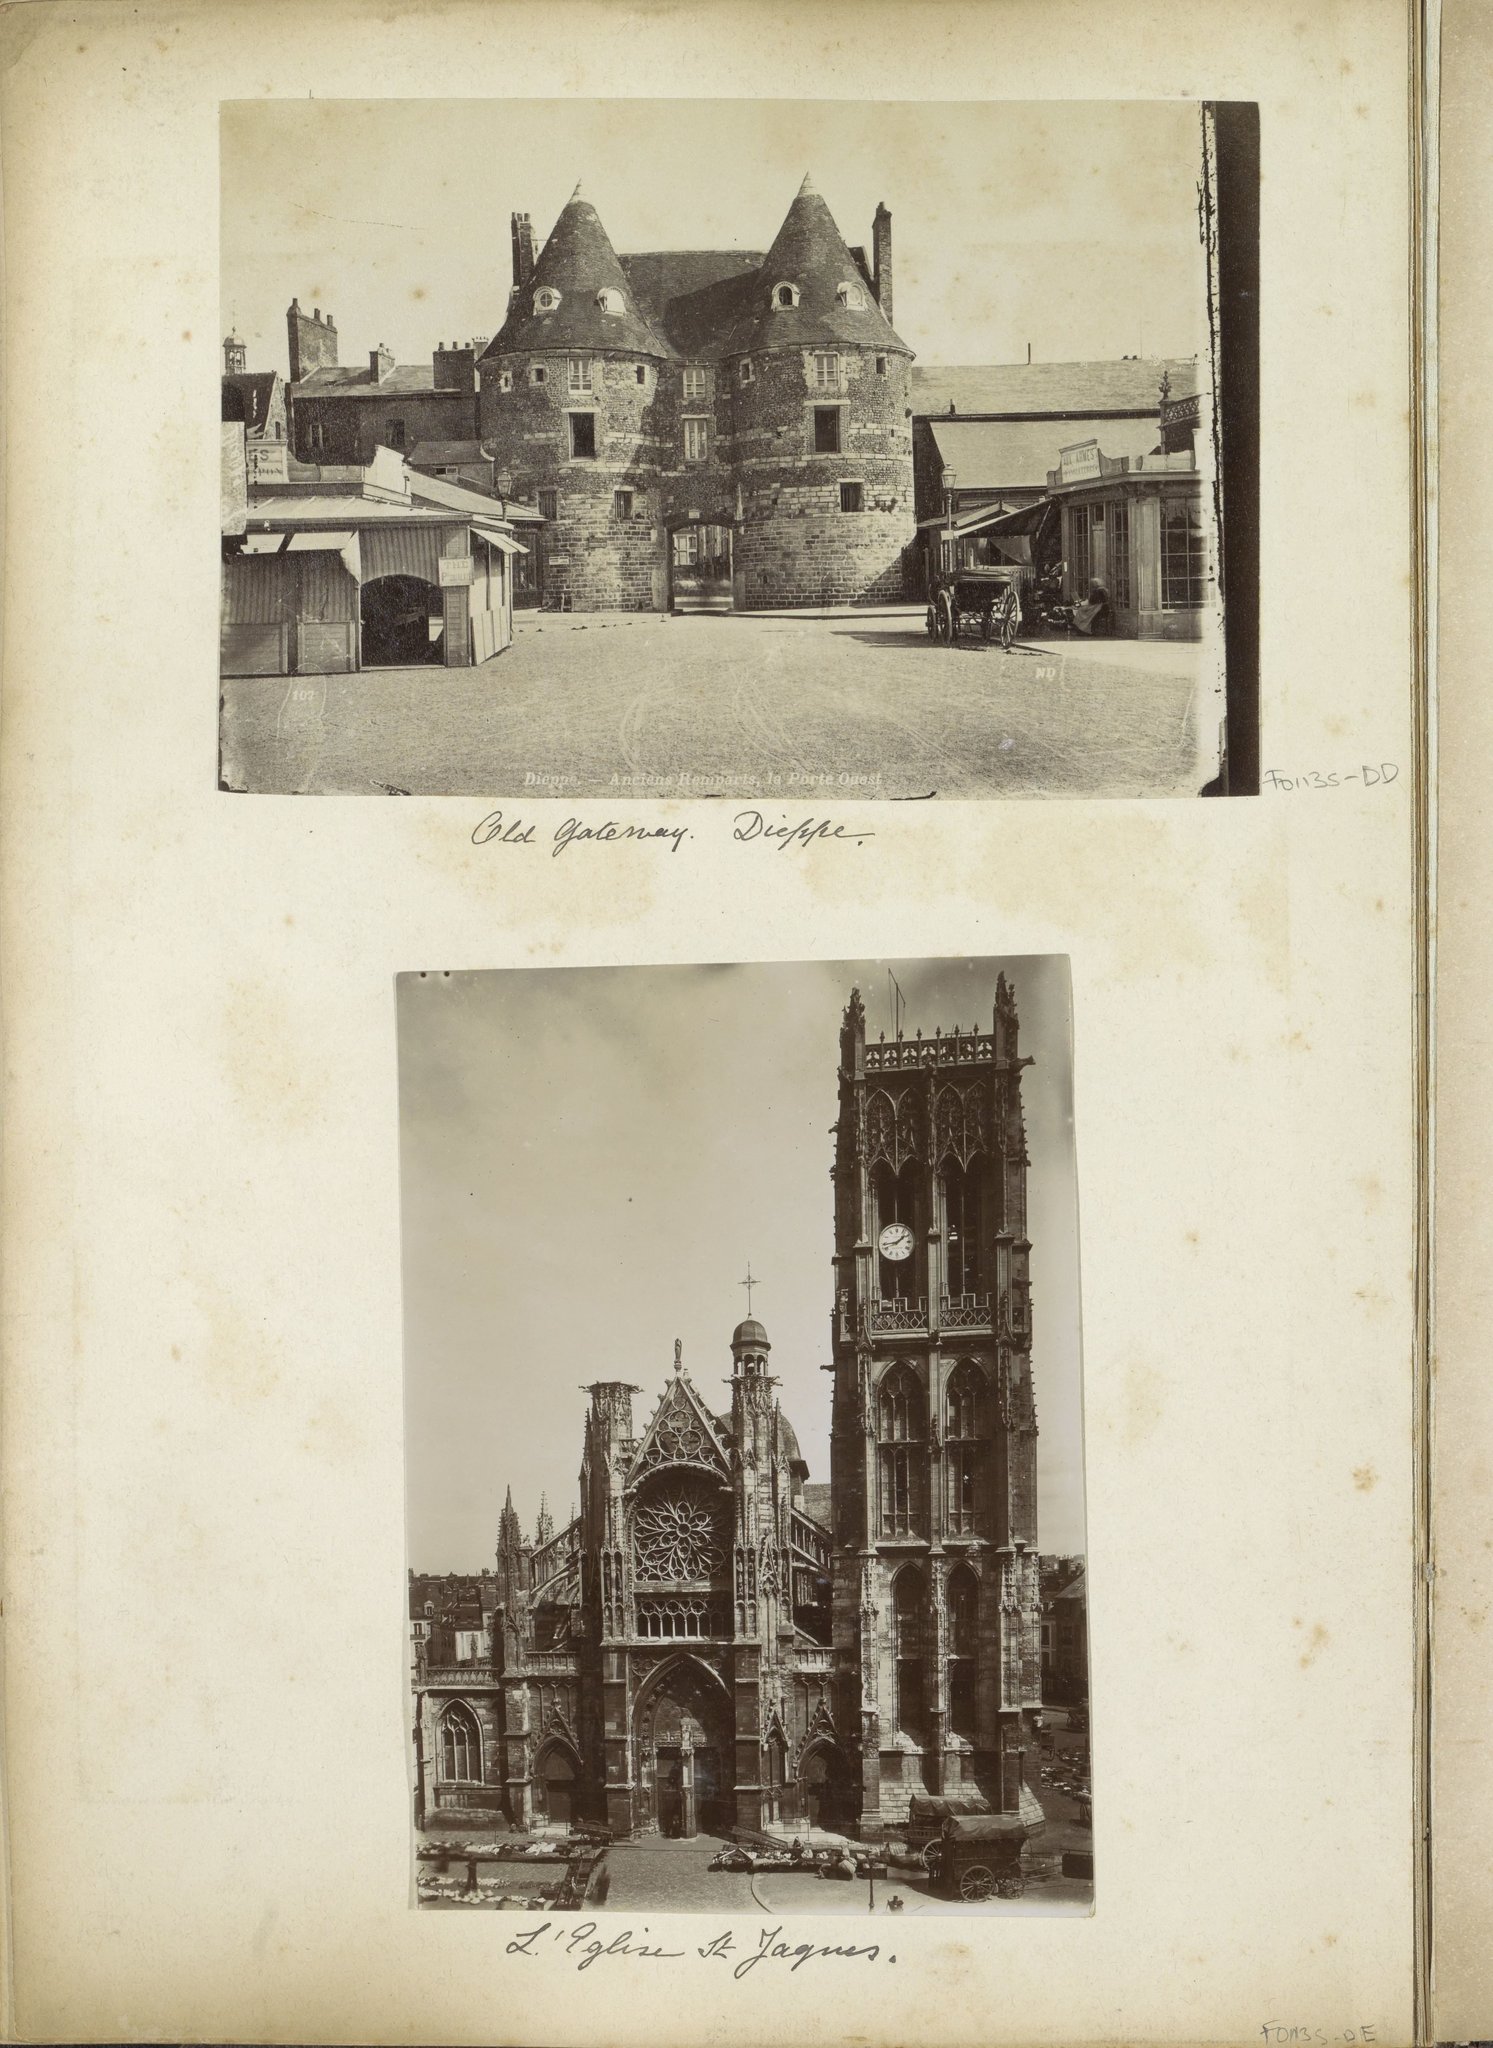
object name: album leaf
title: Exterieur van Église Saint-Jacques in Dieppe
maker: Anonymous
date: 1901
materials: paper, photographic support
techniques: daylight paper print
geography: dieppe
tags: parts of church exterior and annexes: portal, church (exterior), clock, parts of church exterior and annexes: tower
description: Onderdeel van Reisalbum met foto's van bezienswaardigheden in Engeland en Frankrijk.